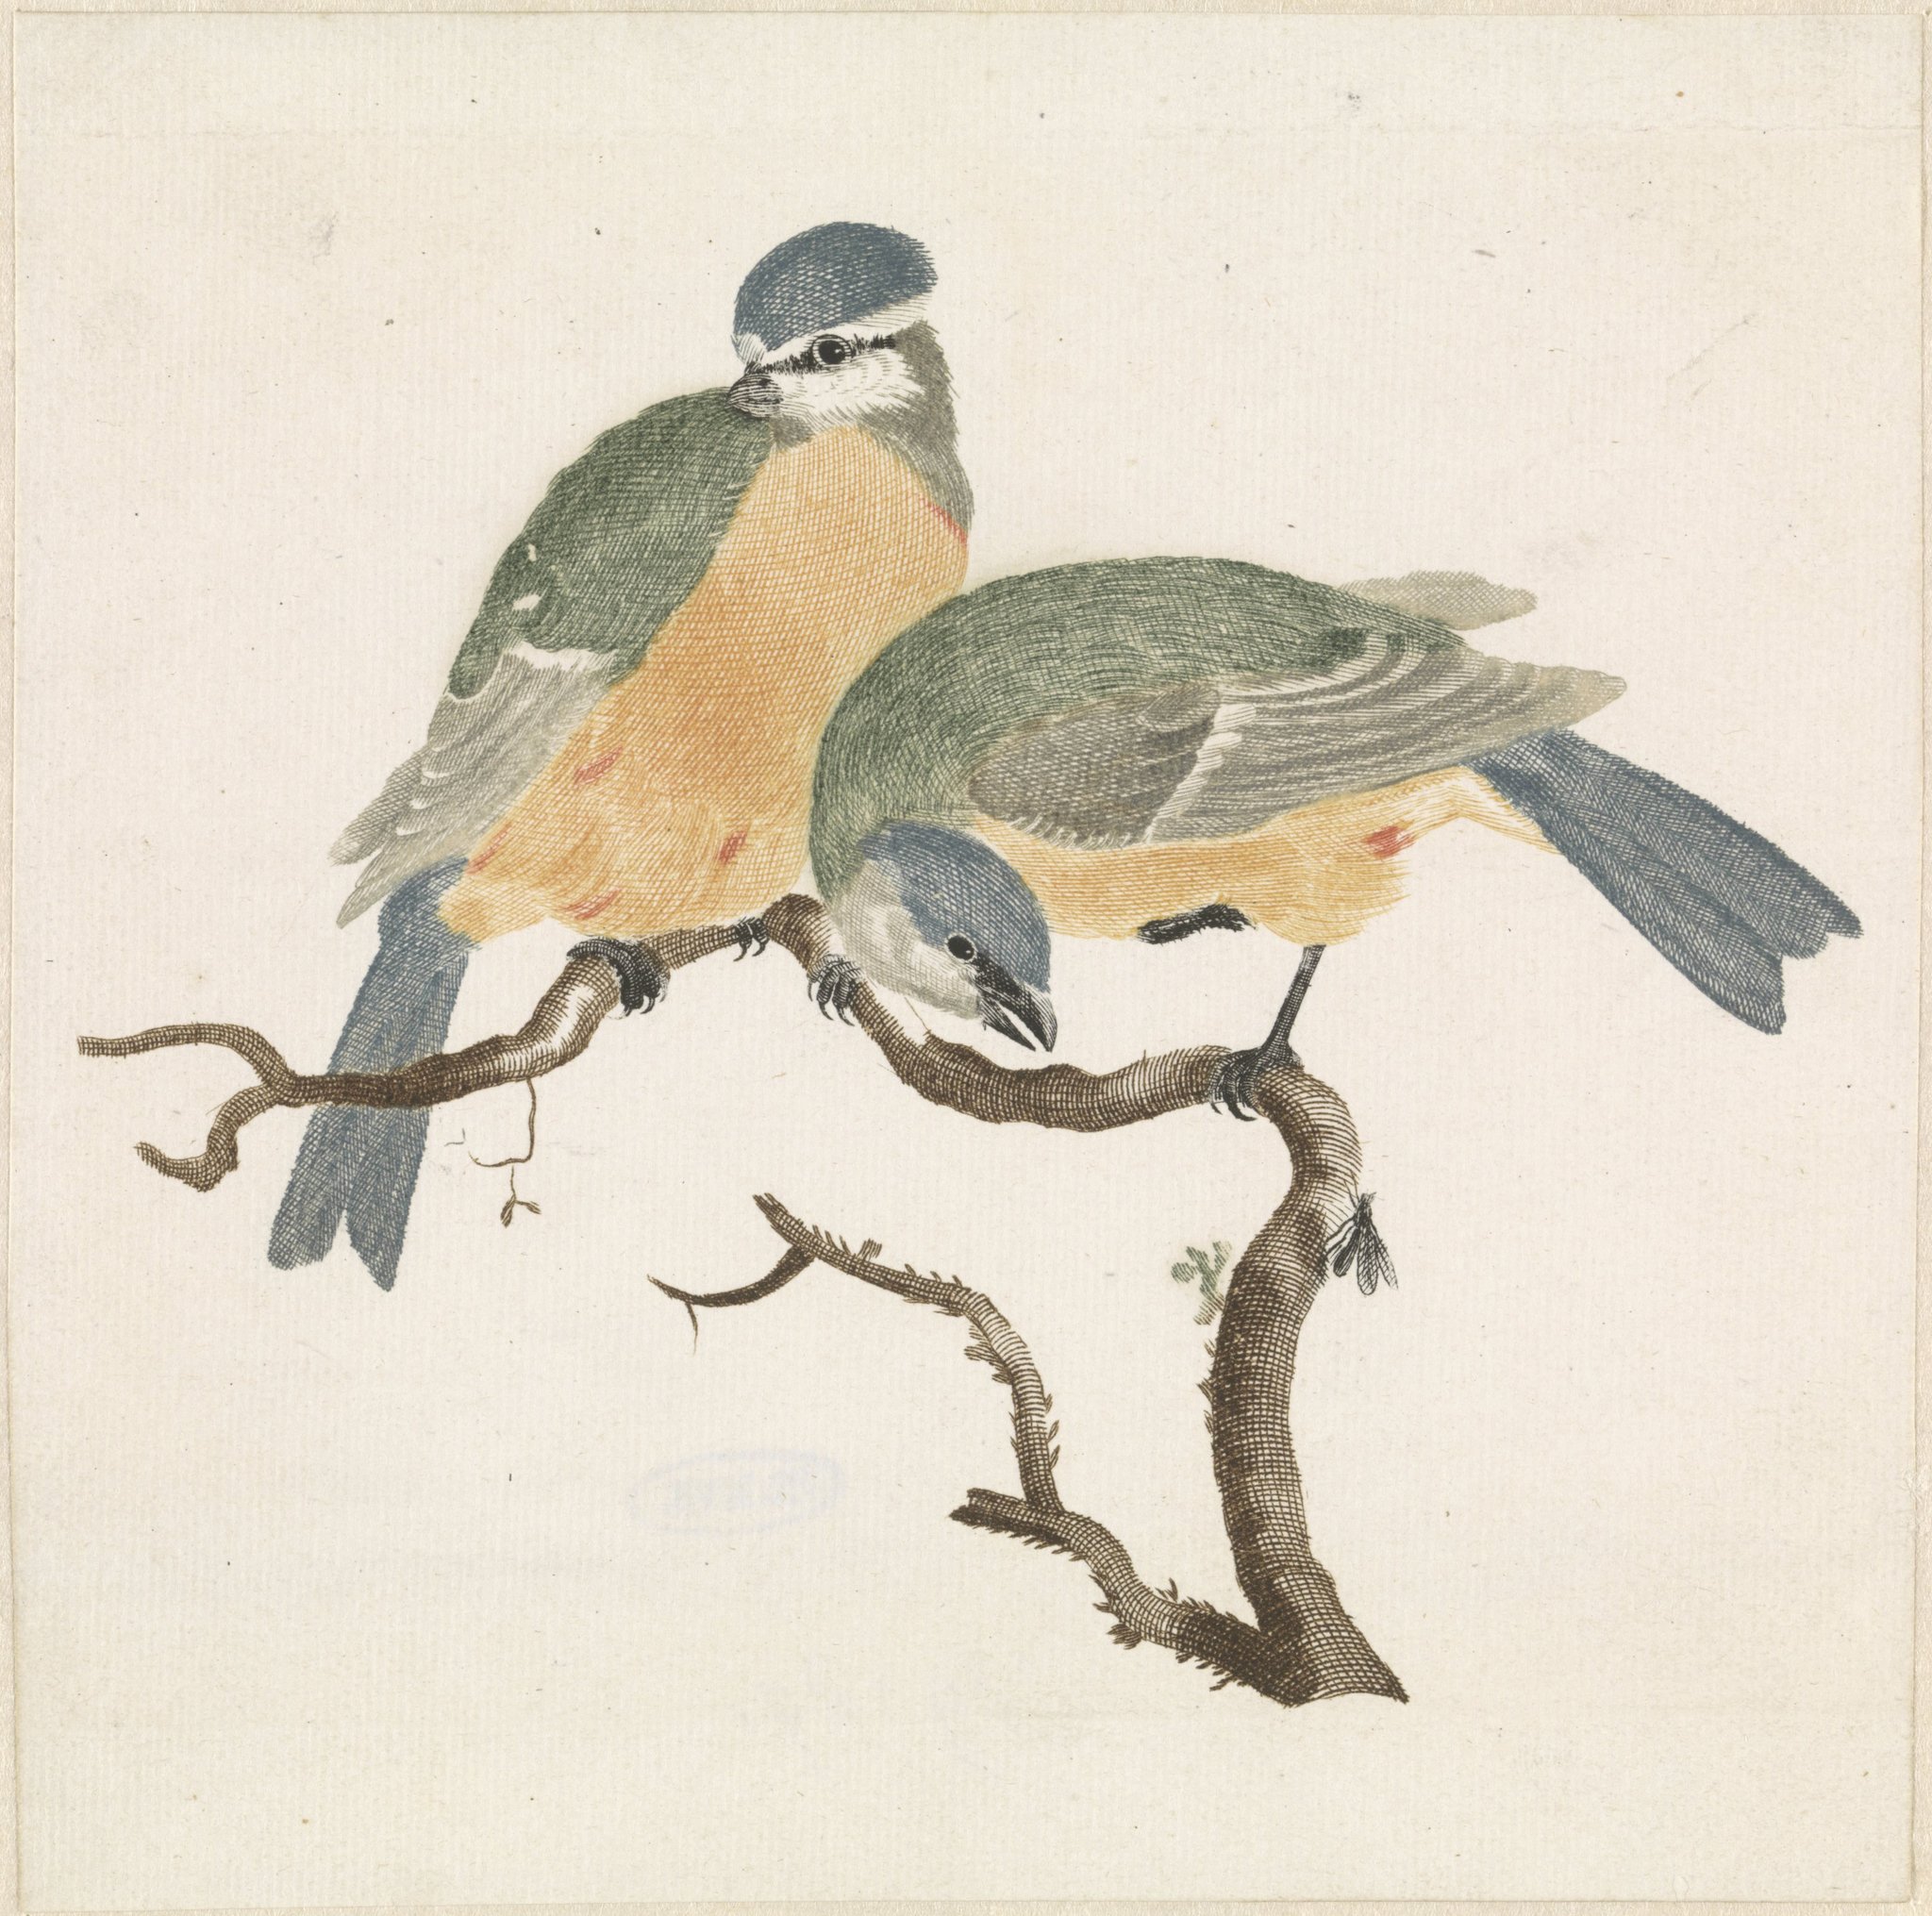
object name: print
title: Een Pimpelmees en een Koolmees op een tak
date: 1688-1698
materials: paper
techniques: printing, engraving, lithography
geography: netherlands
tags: song-birds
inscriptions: collector's mark: Lugt 2228, collector's mark: Lugt 2760